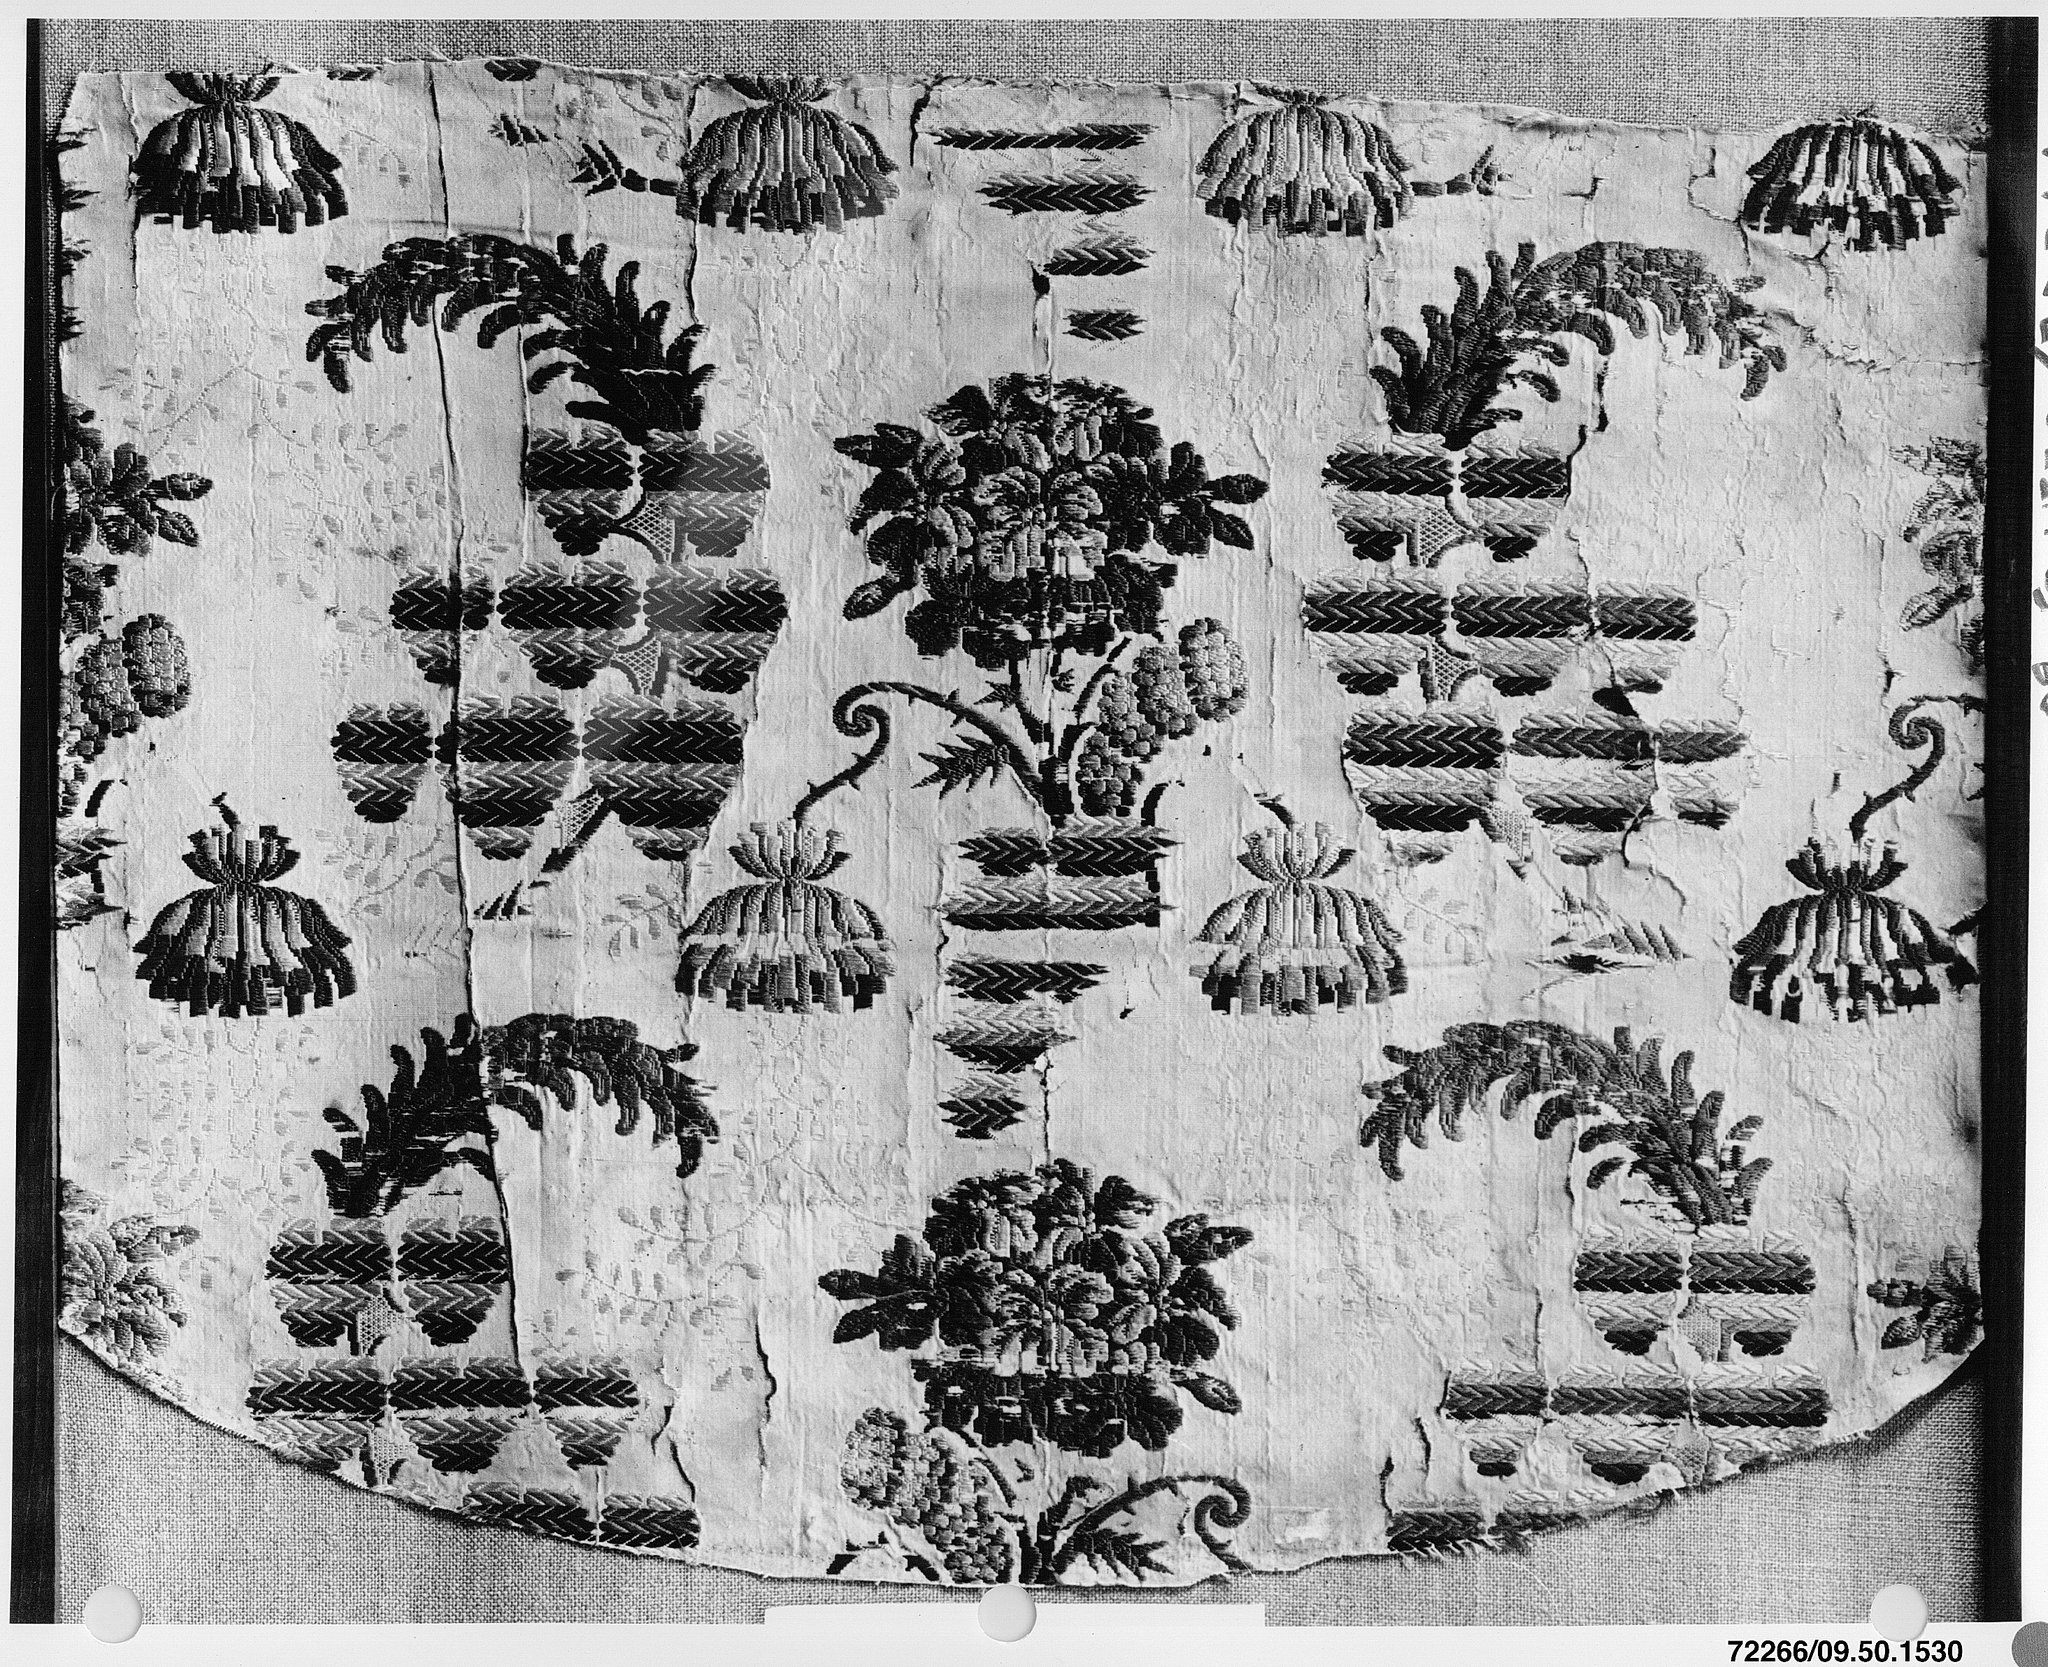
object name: piece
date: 1760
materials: silk